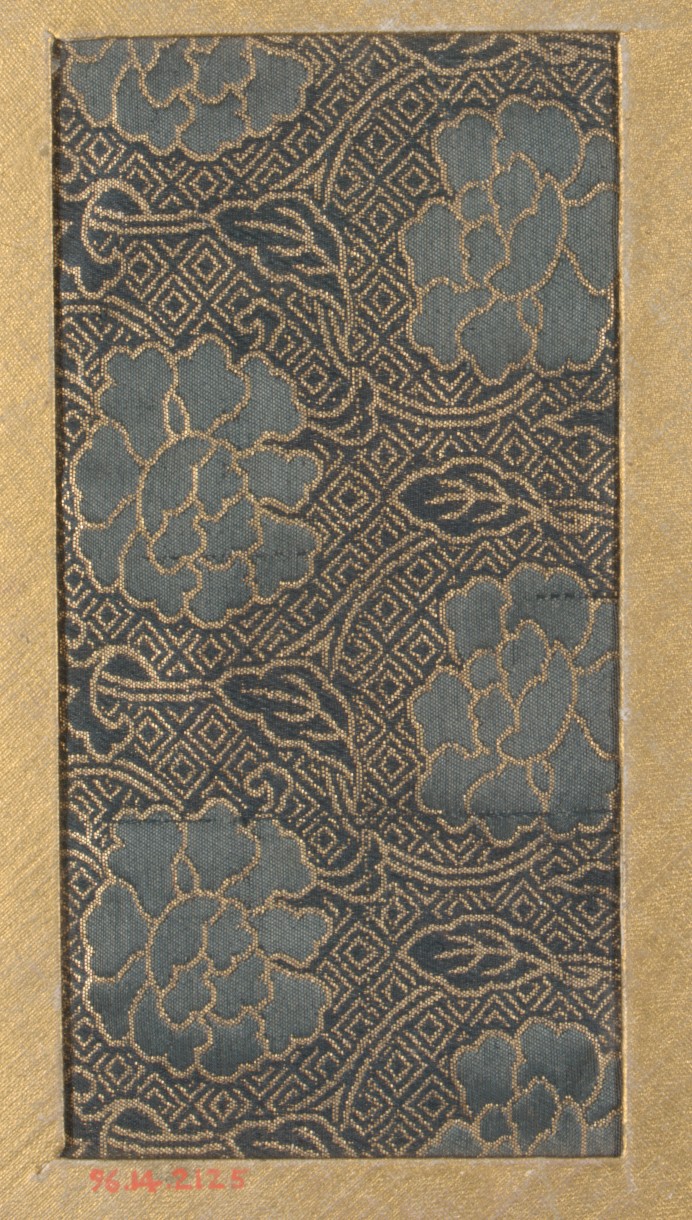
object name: piece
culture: japanese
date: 1701-1900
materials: silk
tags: flowers